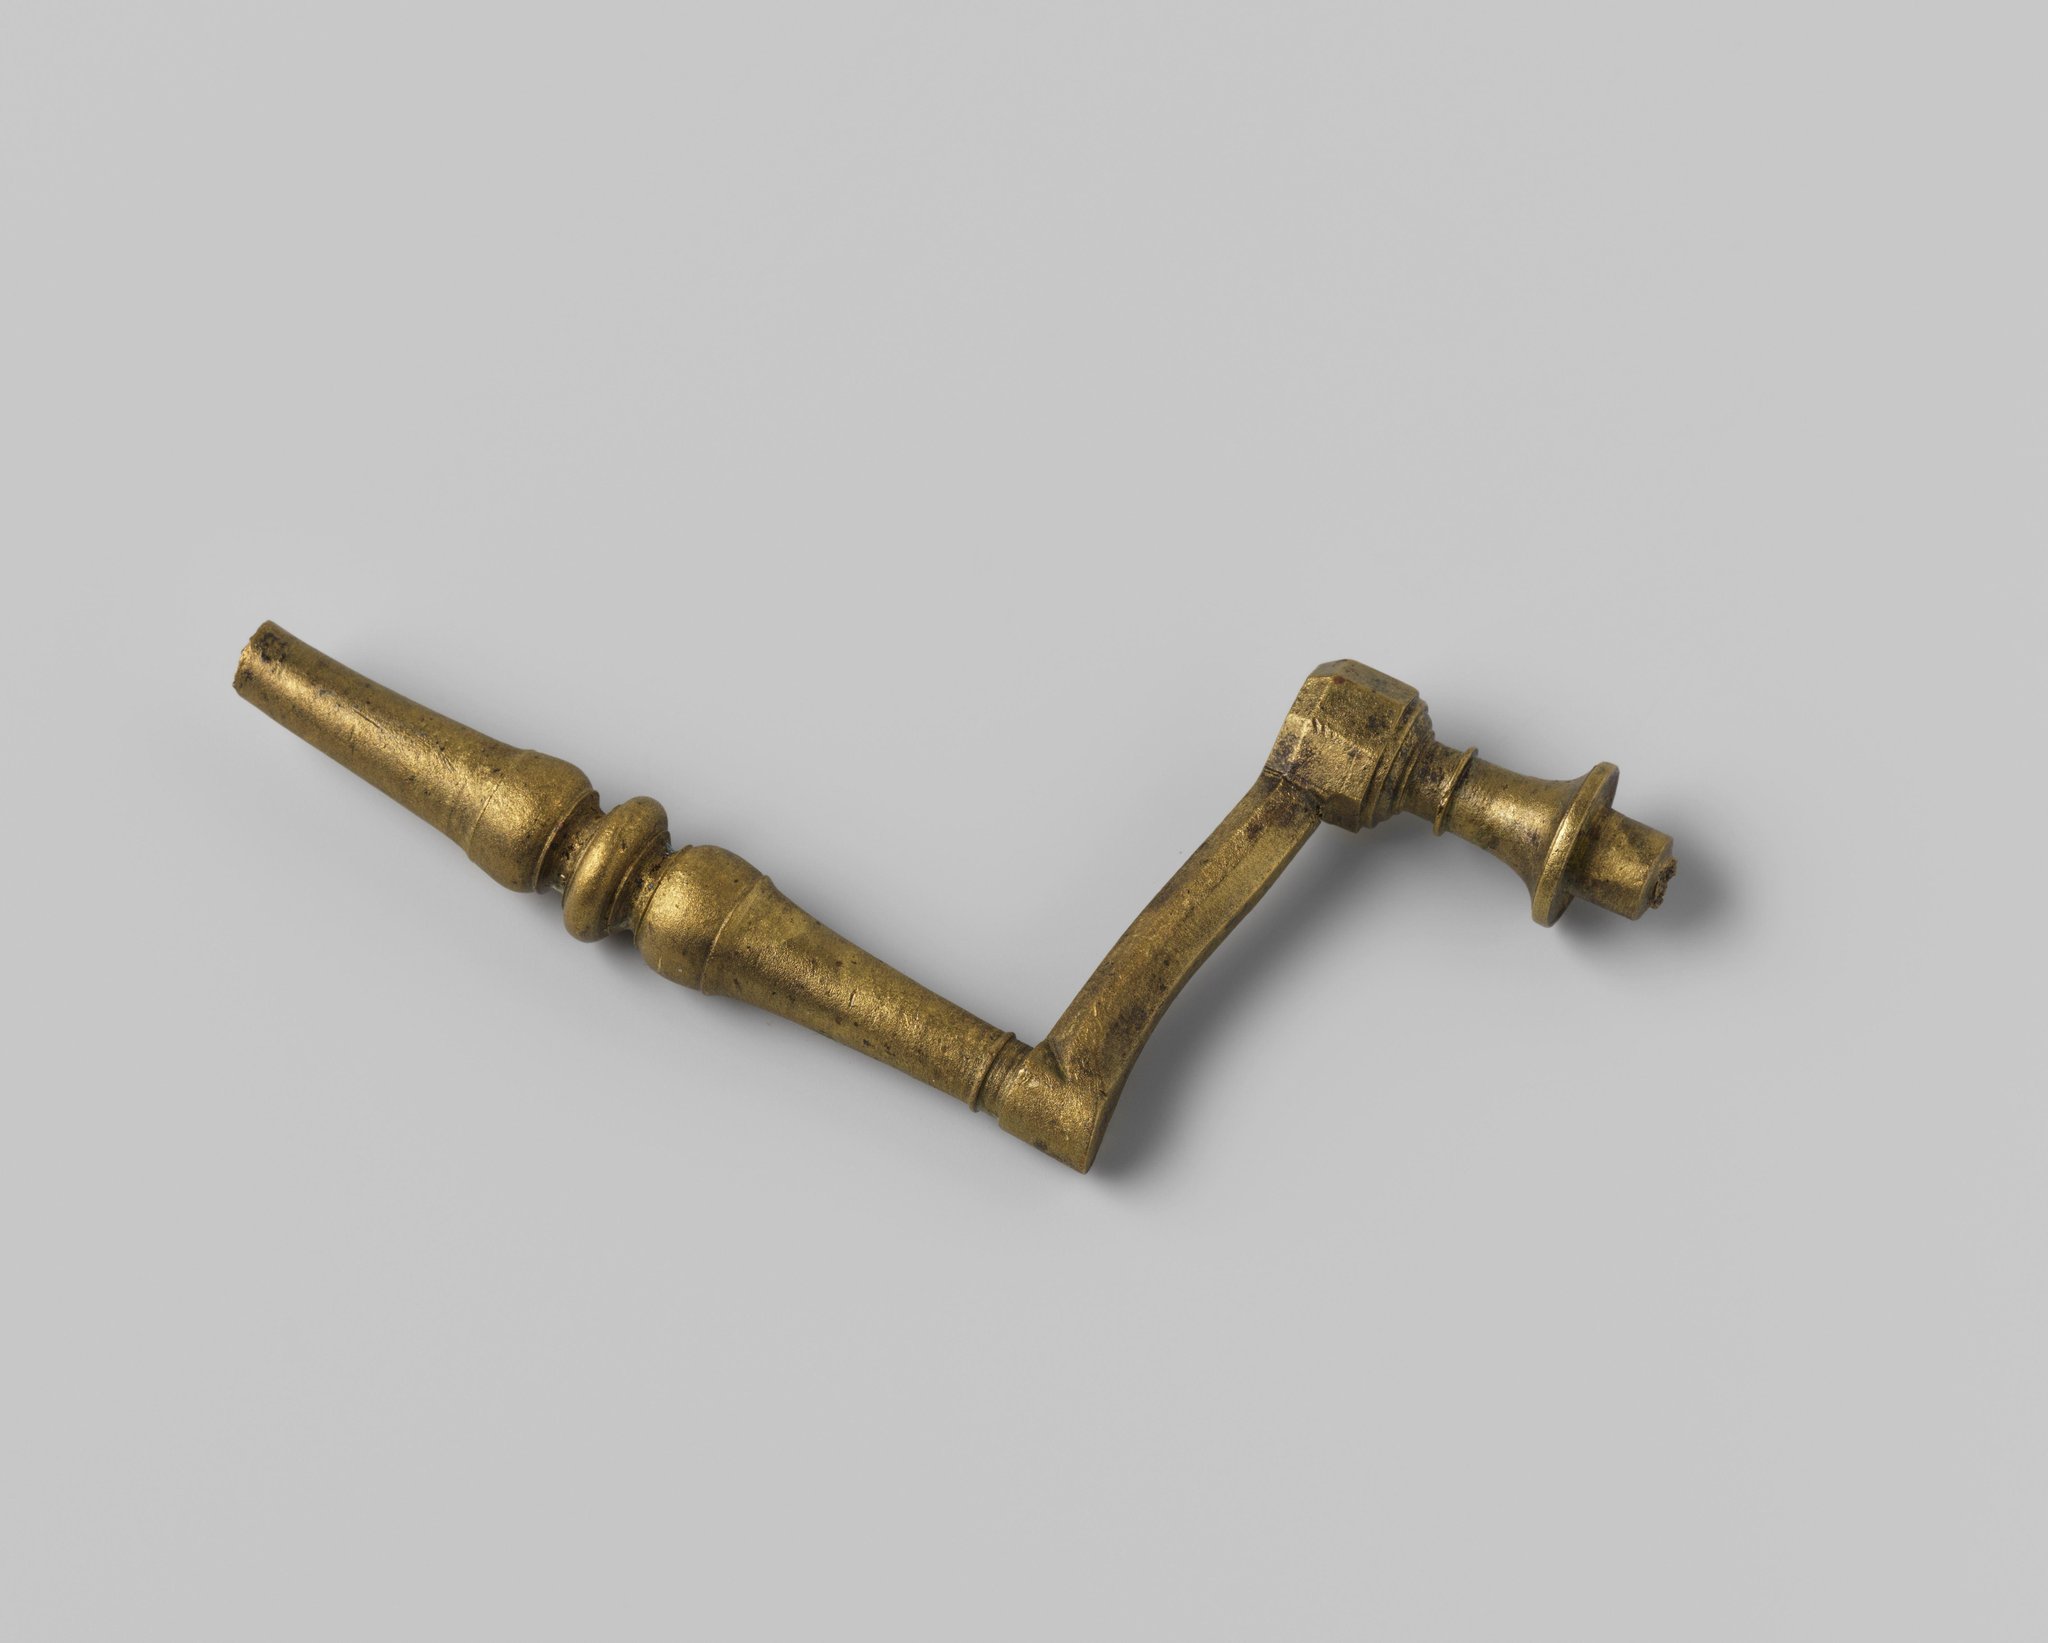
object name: trephine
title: Trepanation drill from the wreck of the Dutch East Indiaman Meresteijn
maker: Anonymous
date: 1693-1702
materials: brass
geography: netherlands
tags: cape of good hope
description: Deel van de omslag van een trepaan, een boor die de chirurgijn kon gebruiken om de schedel van een patiënt open te leggen.